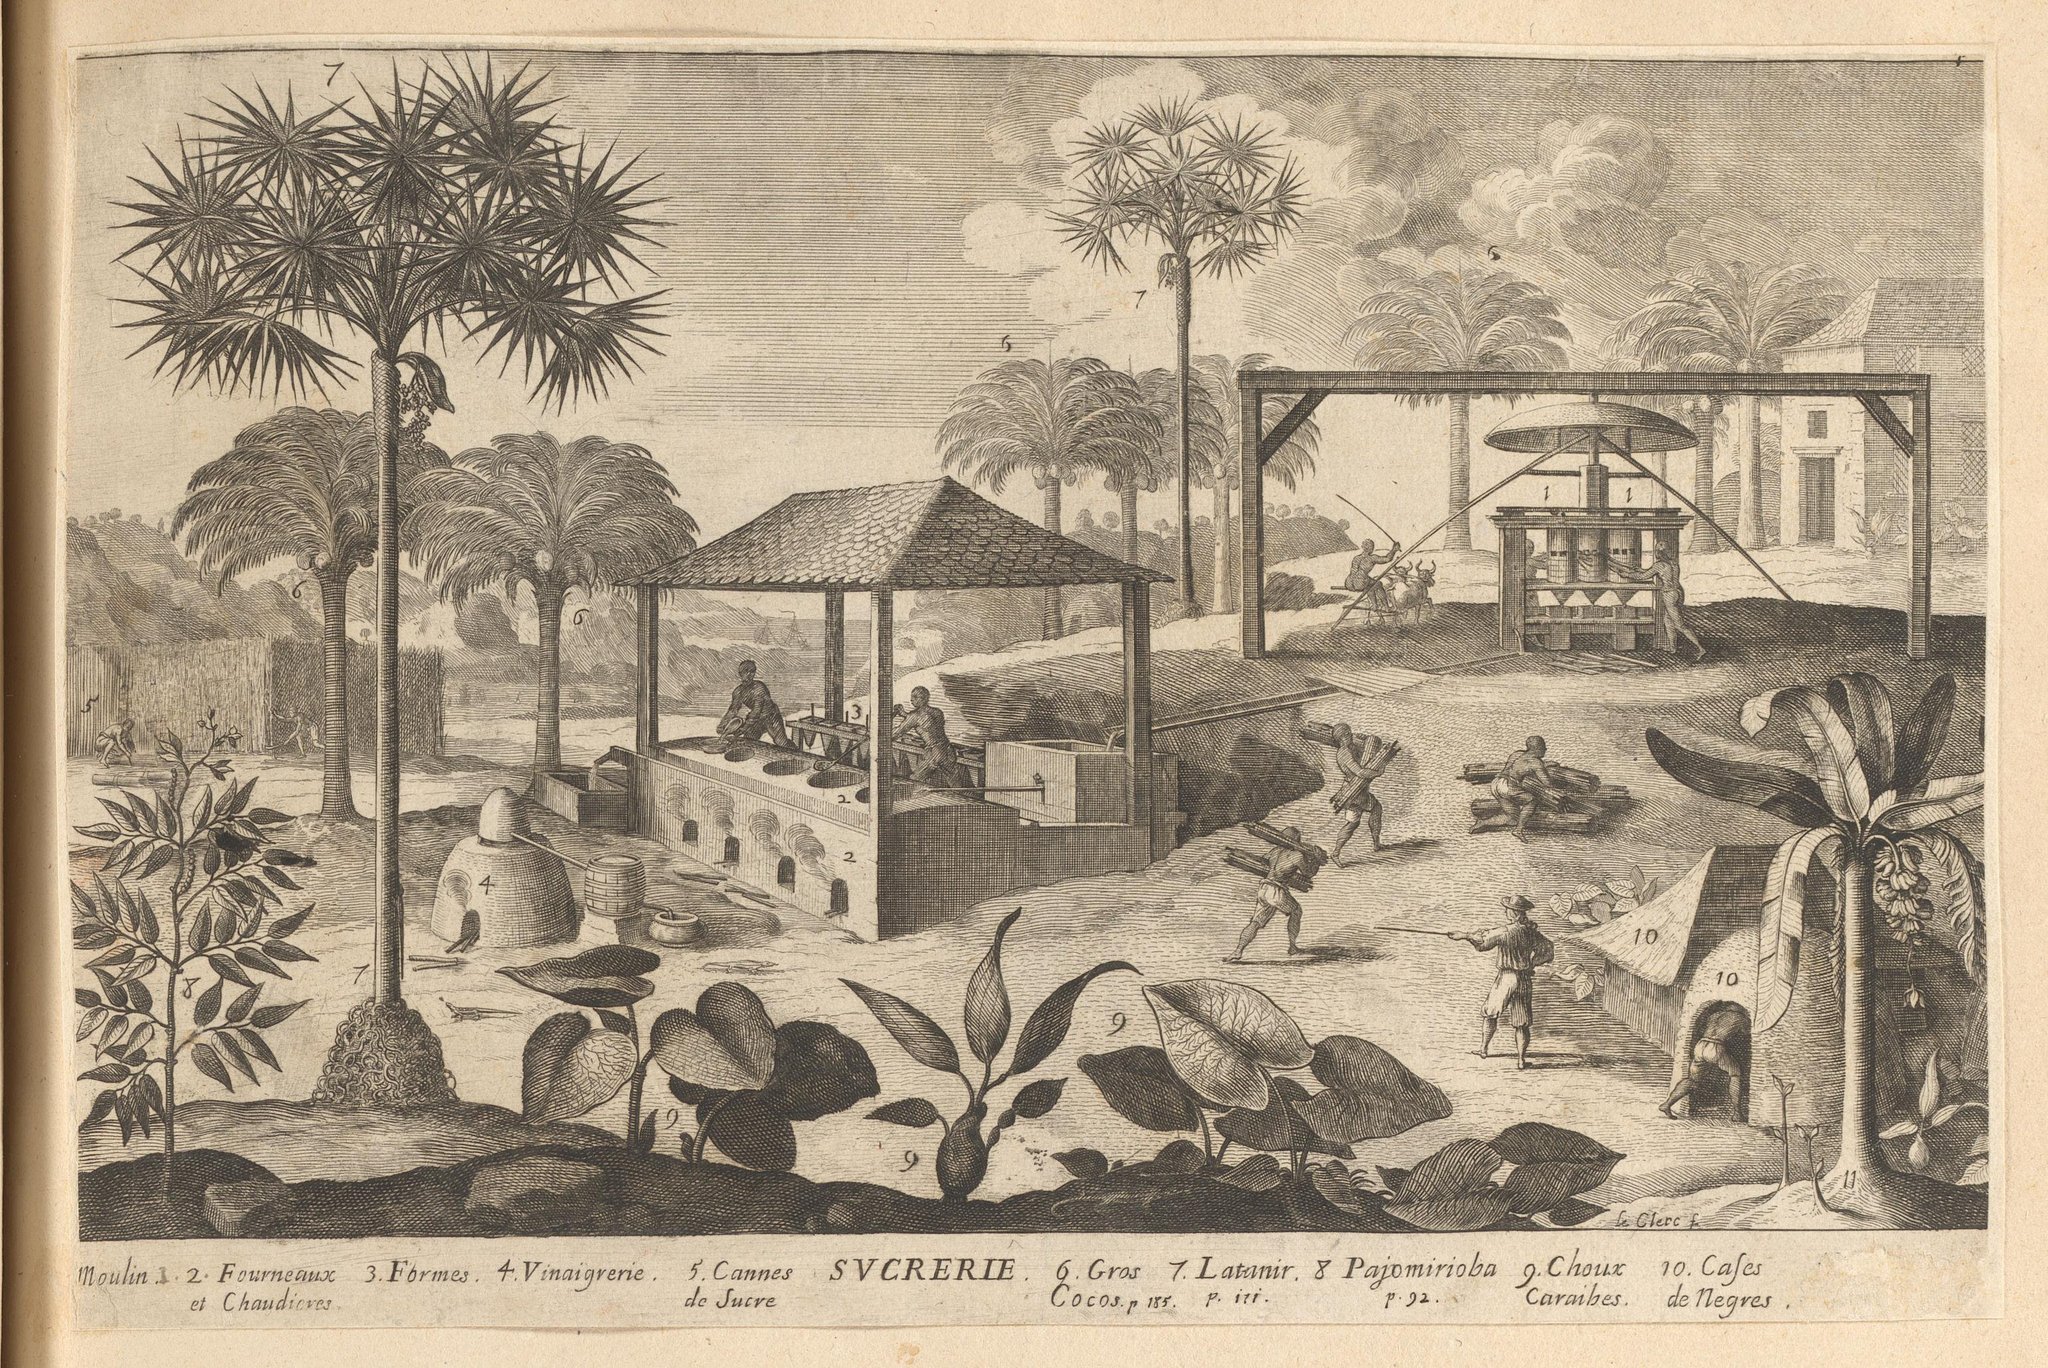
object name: print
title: Sucerie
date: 1667-1671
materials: paper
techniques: etching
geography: paris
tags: master ~ enslaved person, plantation, indigenous peoples of the caribbean, slavery; serfs and enslaved persons, sugar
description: Gezicht op een suikerraffinaderij of suikerbakkerij op de Franse Antillen, waar tot slaaf gemaakte mannen werken. Rechtsboven de molen waar het suikerriet wordt gebroken, tot pulp geplet en waar er siroop van wordt gebrouwen. In het midden links de ovens waar de suiker wordt gekristalliseerd en in kegels wordt gegoten tot suikerbroden. Links op de achtergrond wordt op een suikerrietplantage het suikerriet geoogst, dat door mannen naar de raffinaderij wordt gedragen. Over de gehele prent zijn verschillende planten en bomen weergegeven voorzien van nummers die onderin de marge in het Frans worden toegelicht. Prent maakt deel uit van een album.